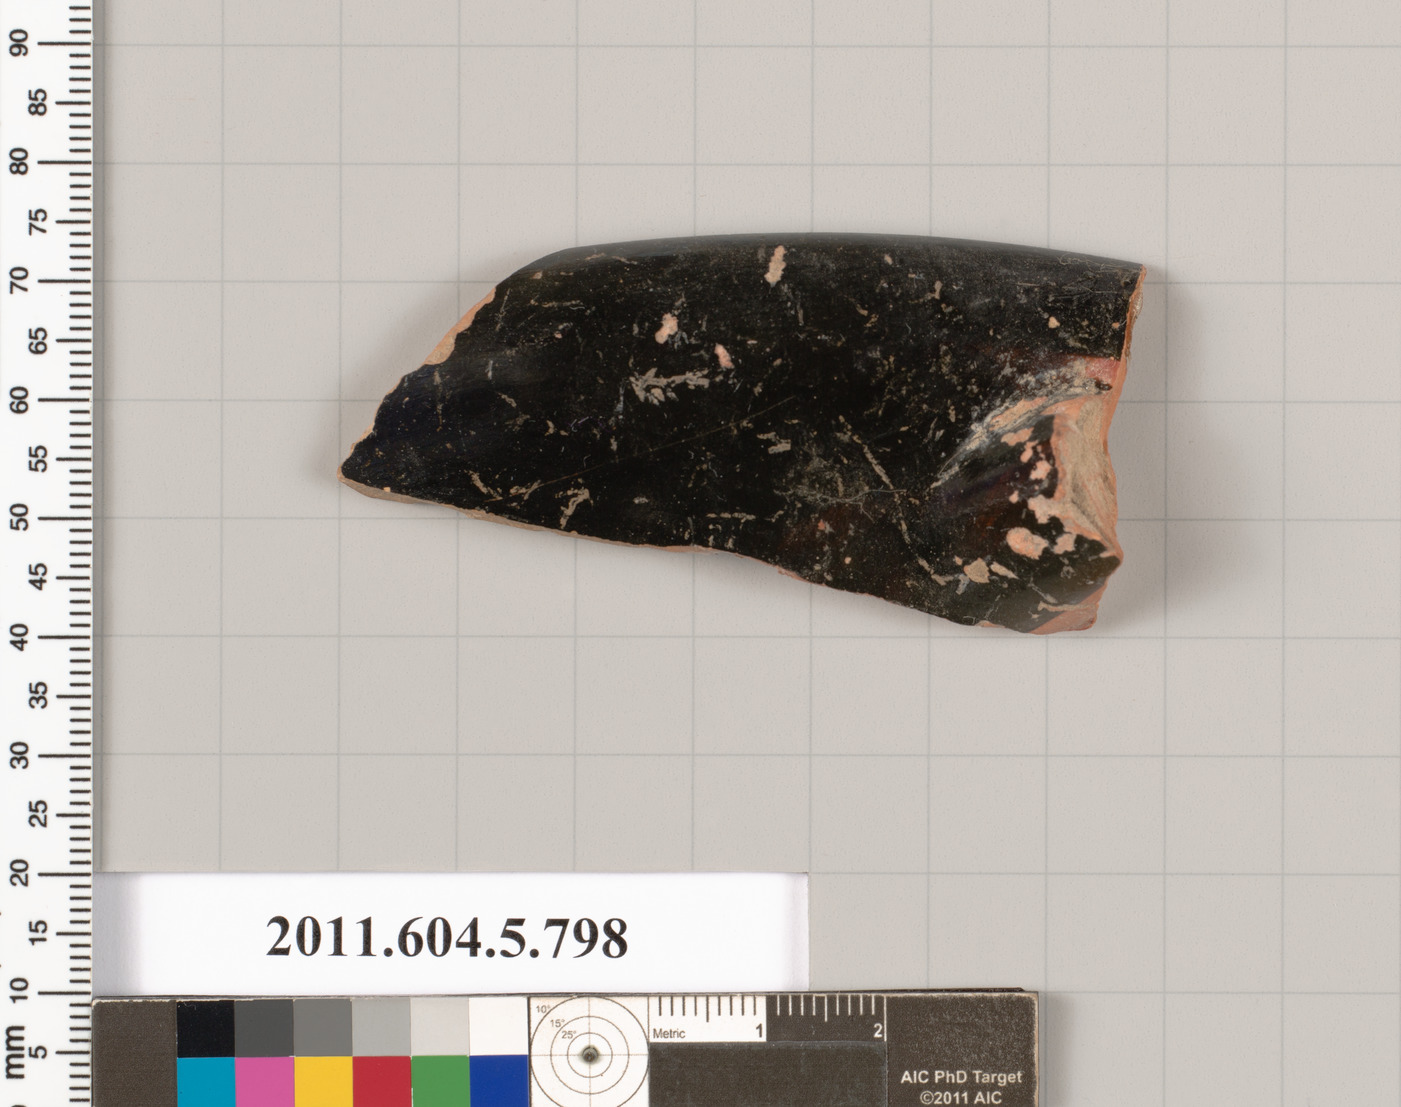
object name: kylix fragment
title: Terracotta rim fragment of a kylix (drinking cup)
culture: greek, attic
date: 600-401 BCE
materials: terracotta